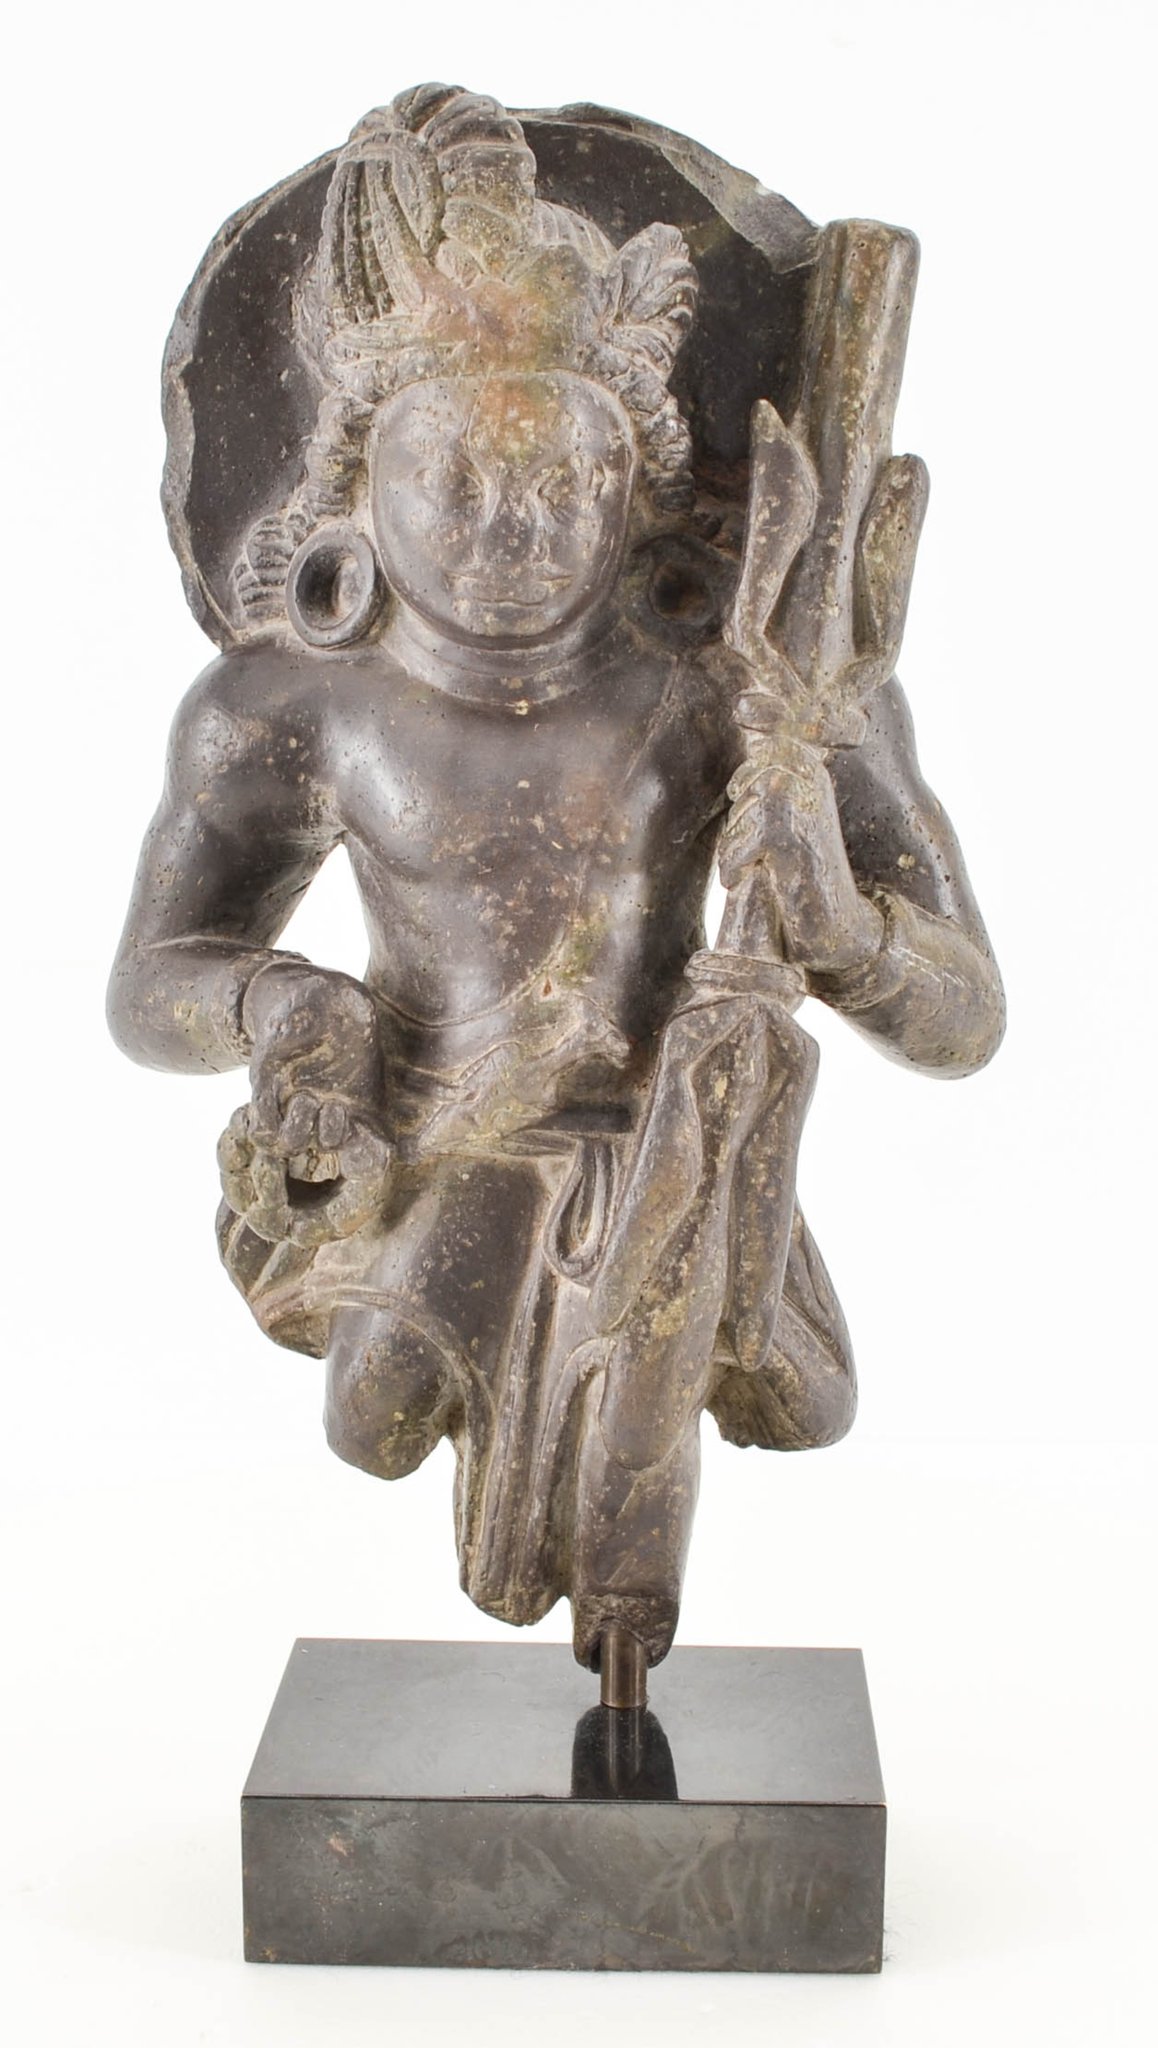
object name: figure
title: Vajrapani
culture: indian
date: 567-700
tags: kashmir,vajrapani